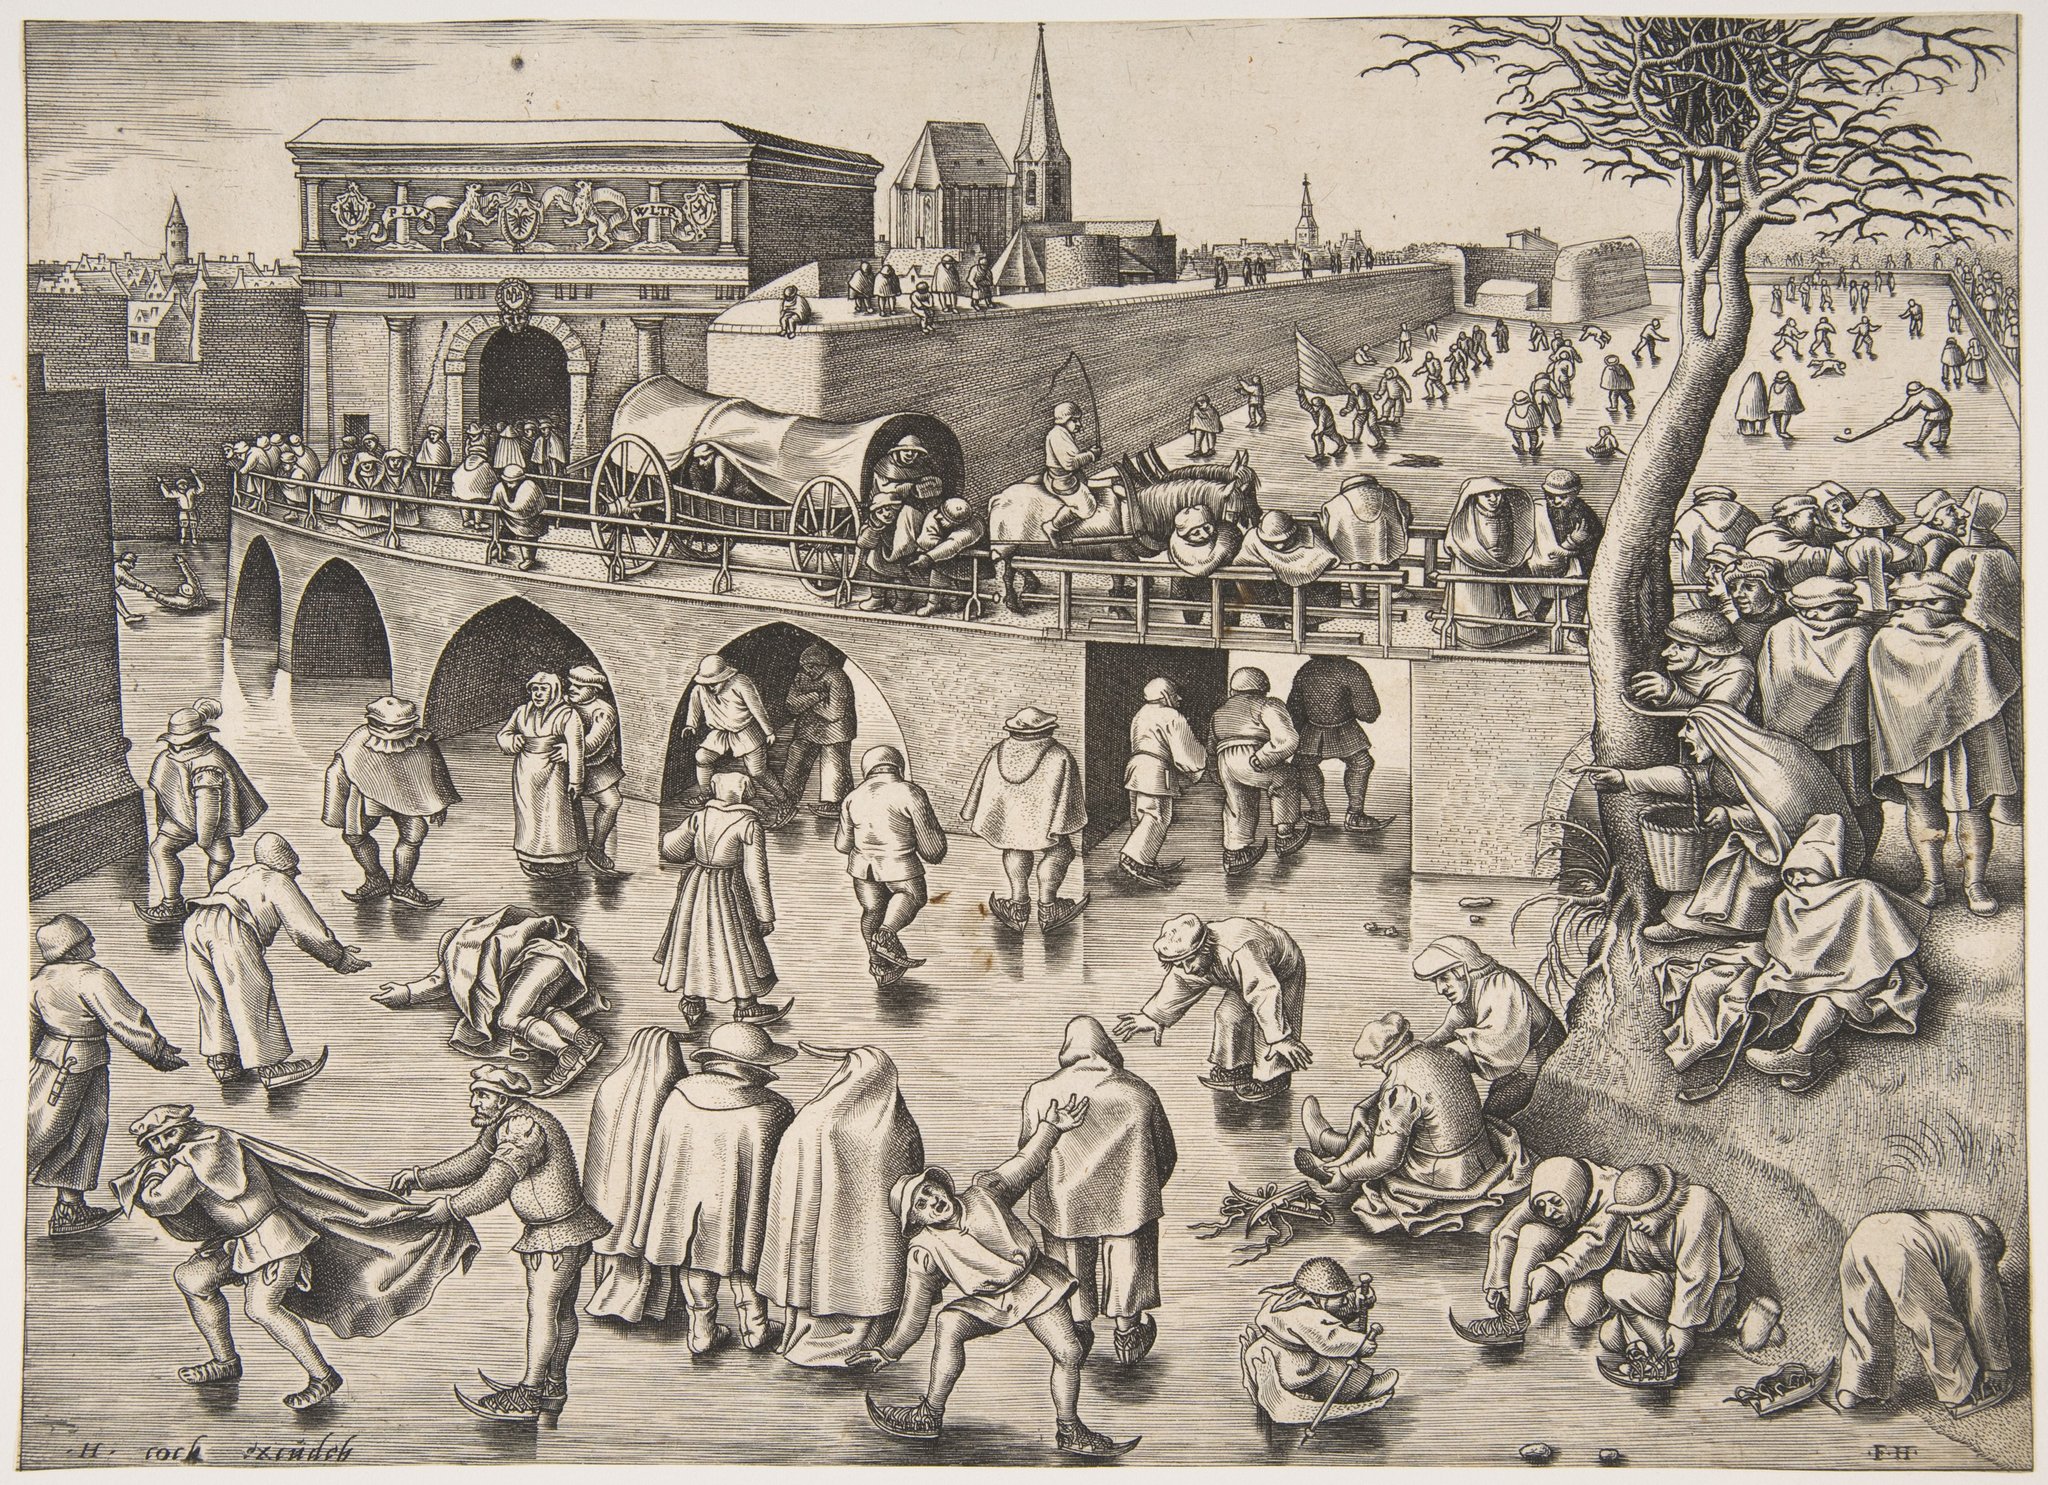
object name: print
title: Skating before the St. George's Gate, Antwerp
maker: pieter bruegel the elder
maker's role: artist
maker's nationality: netherlandish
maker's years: 1525-1569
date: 1558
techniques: engraving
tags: bridges,skating,crowd